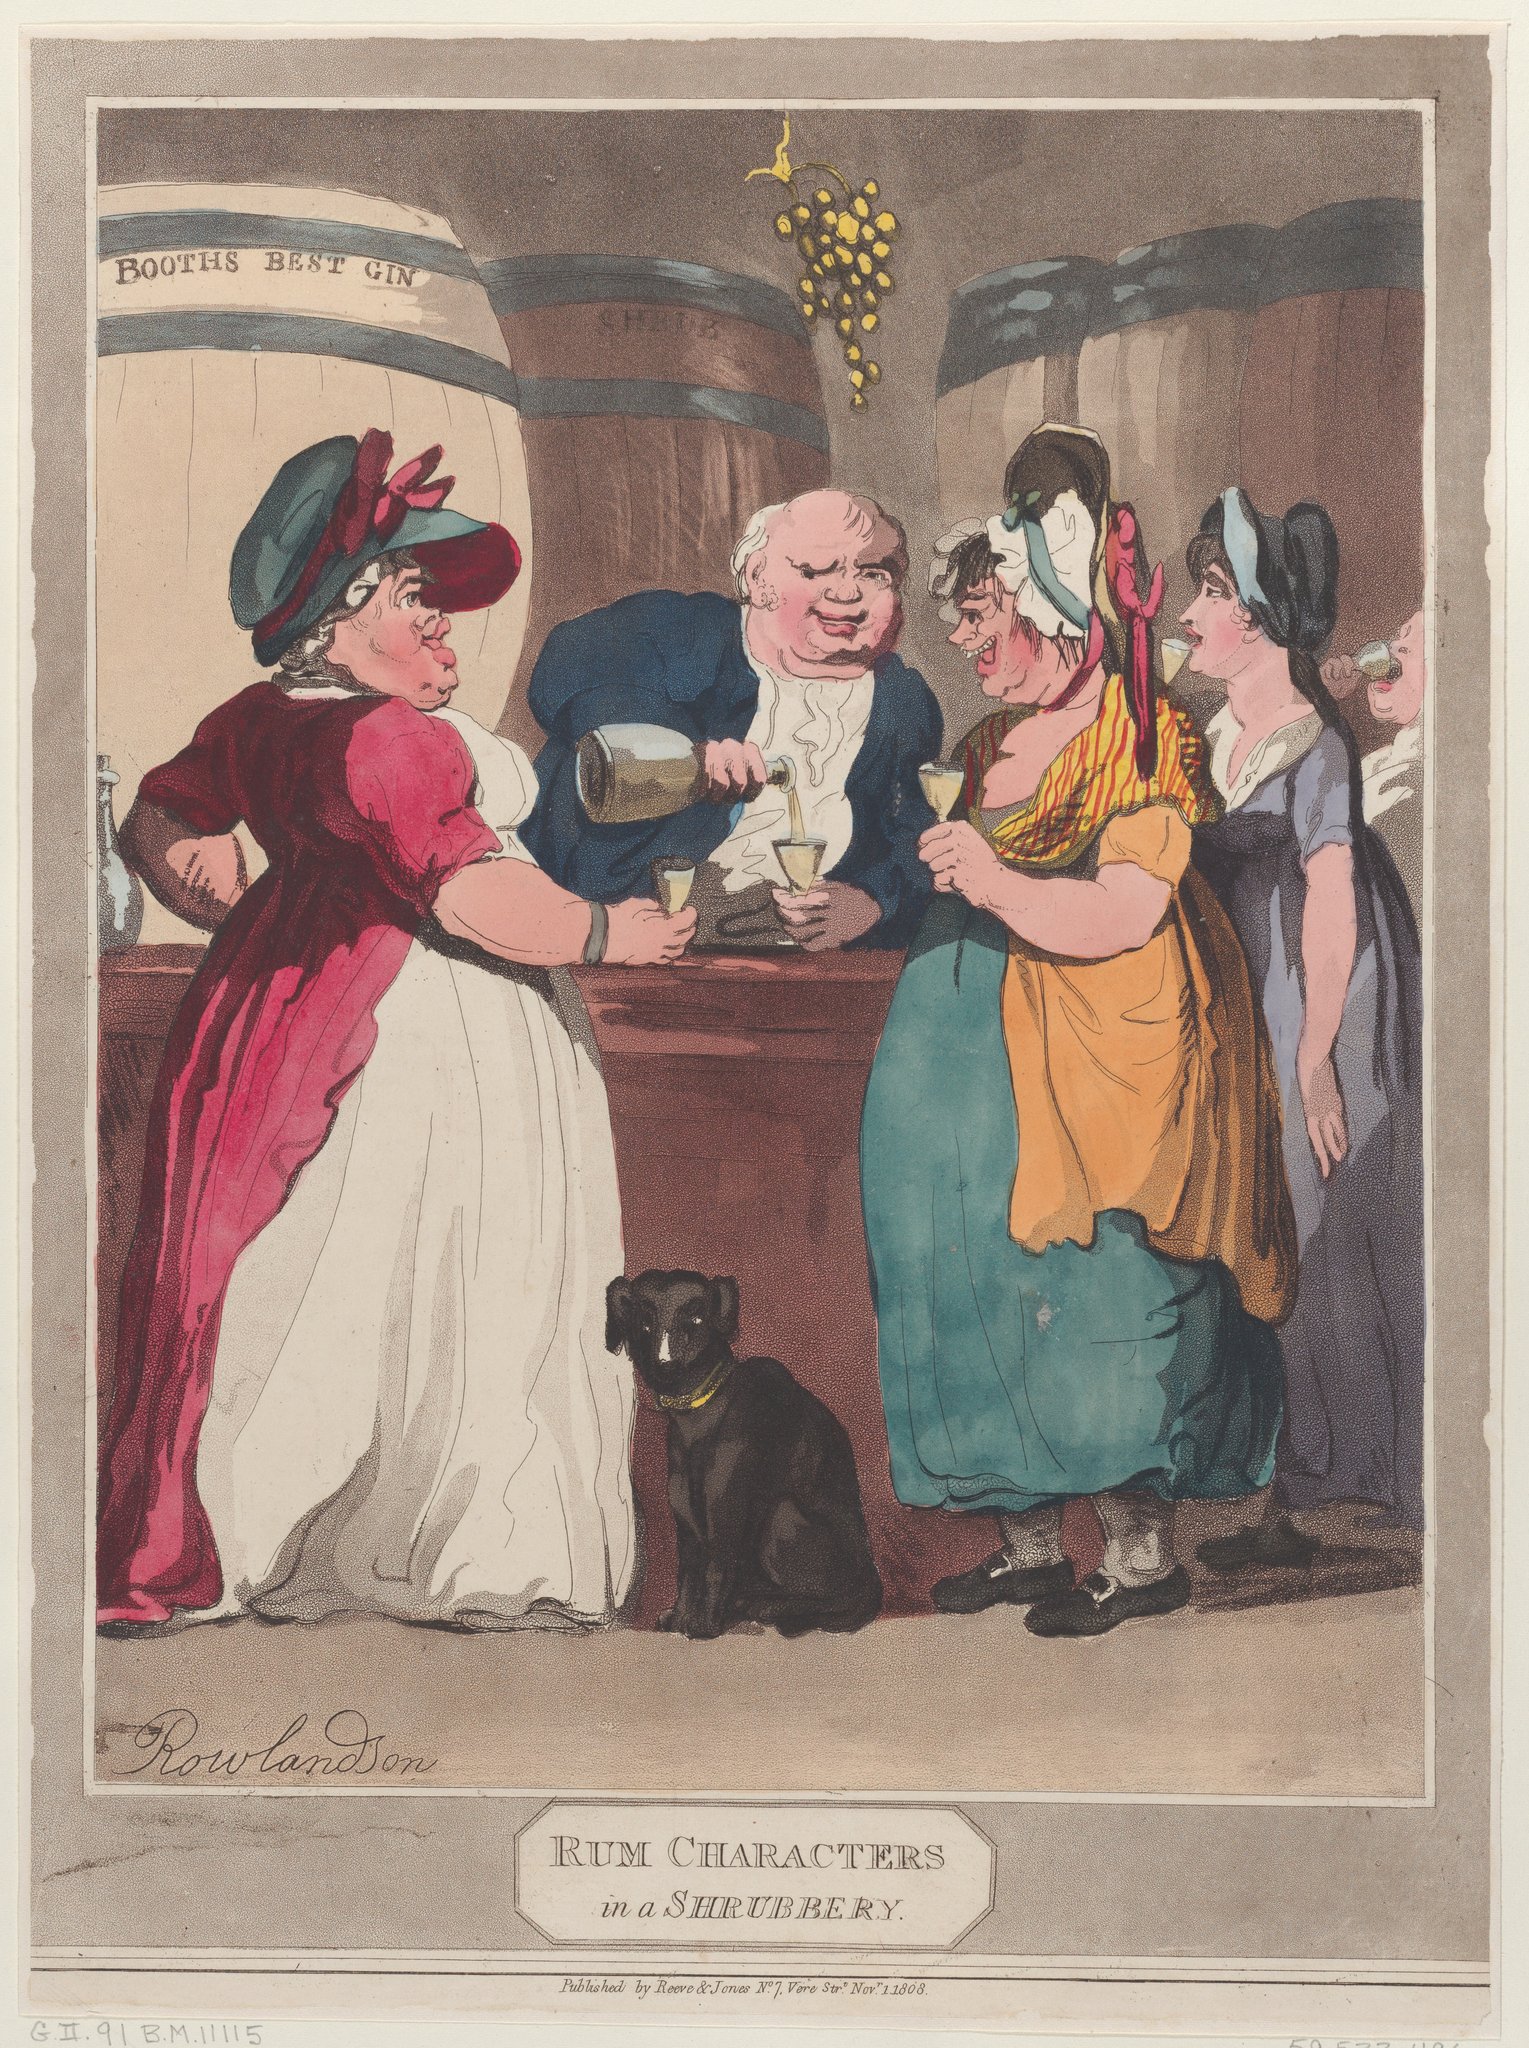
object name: print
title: Rum Characters in a Shrubbery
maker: thomas rowlandson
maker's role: artist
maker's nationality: british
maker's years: 1757-1827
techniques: aquatint, etching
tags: satire,men,women,dogs,drinking